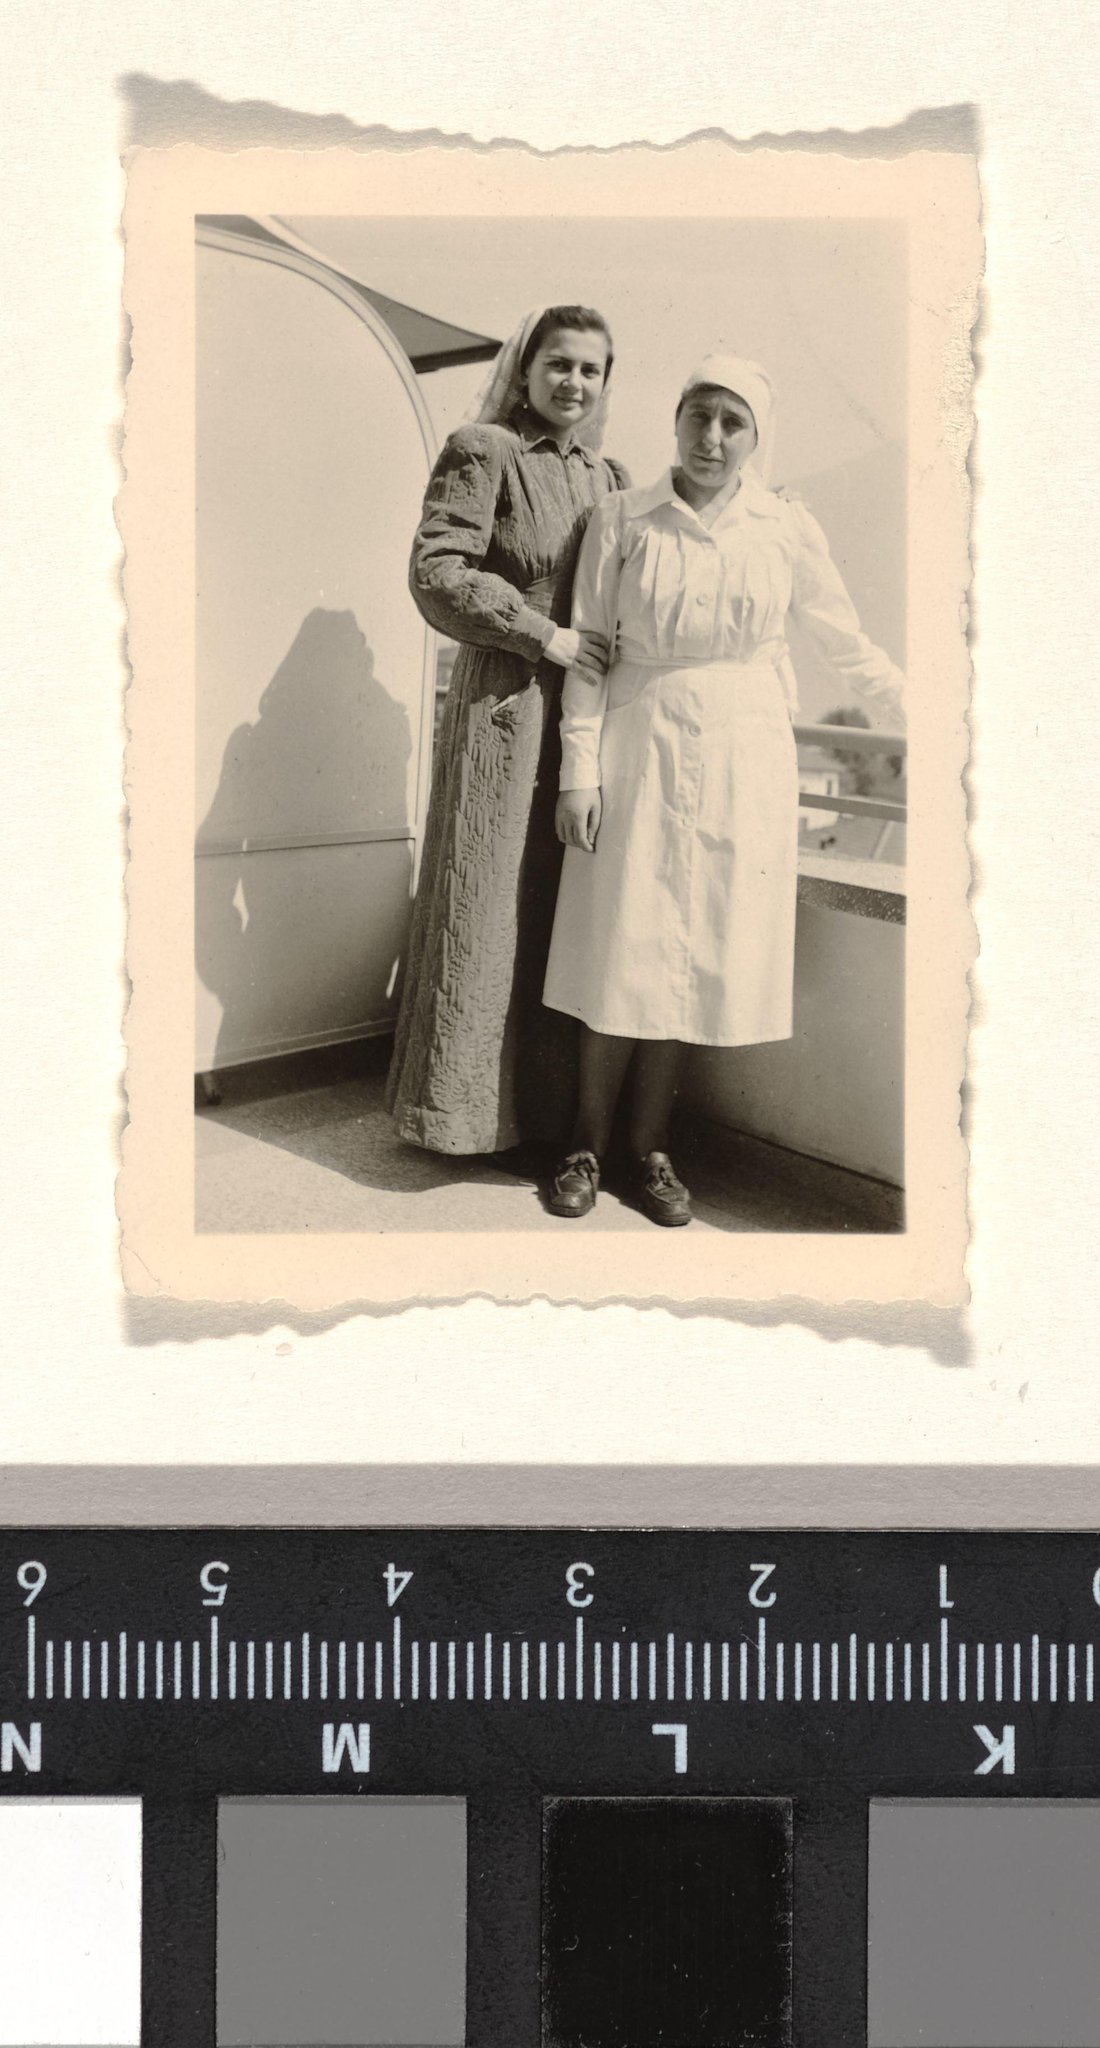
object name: photograph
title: Twee onbekende verpleegsters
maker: Anonymous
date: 1945-1956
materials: photographic support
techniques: gelatin silver print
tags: leiden, isabel wachenheimer-elon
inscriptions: number: ‘15’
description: Twee onbekende verpleegsters. Foto gerelateerd aan de Wachenheimer familie.